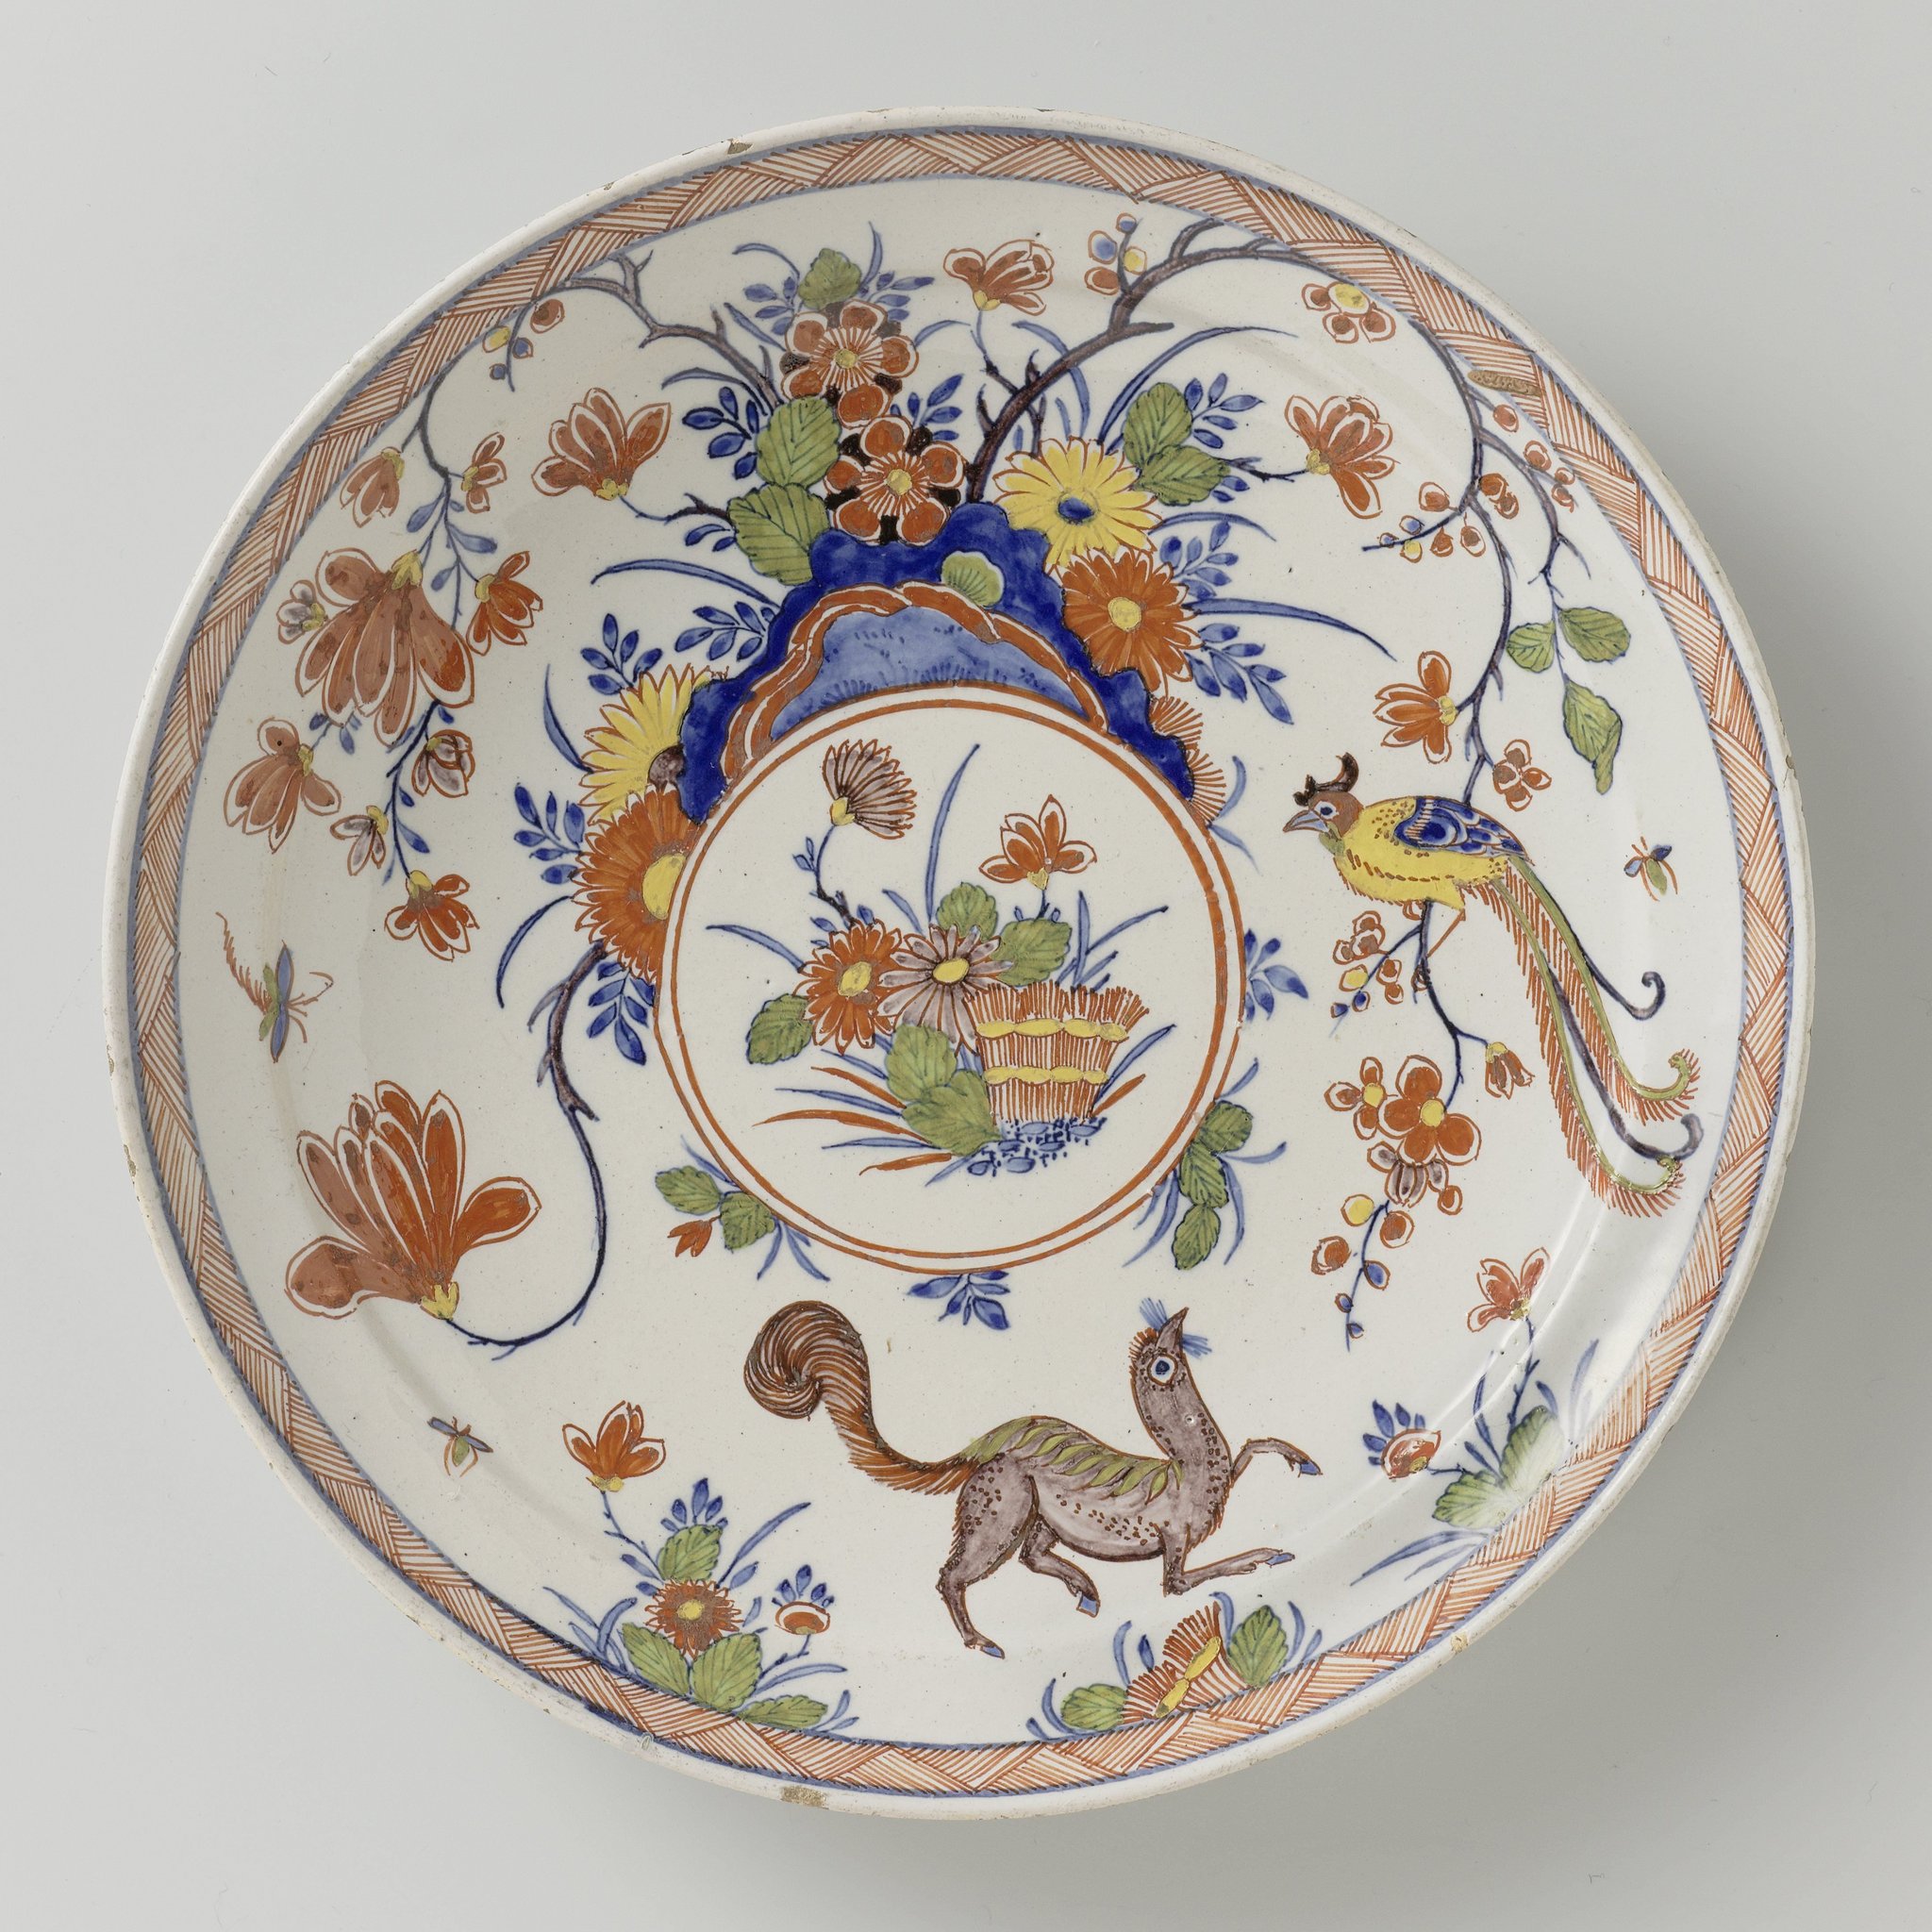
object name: plate dish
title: Bord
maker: Anonymous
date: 1710-1740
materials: faience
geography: delft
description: Bord van faience. Veelkleurig beschilderd naar Japans Kakiemon voorbeeld.